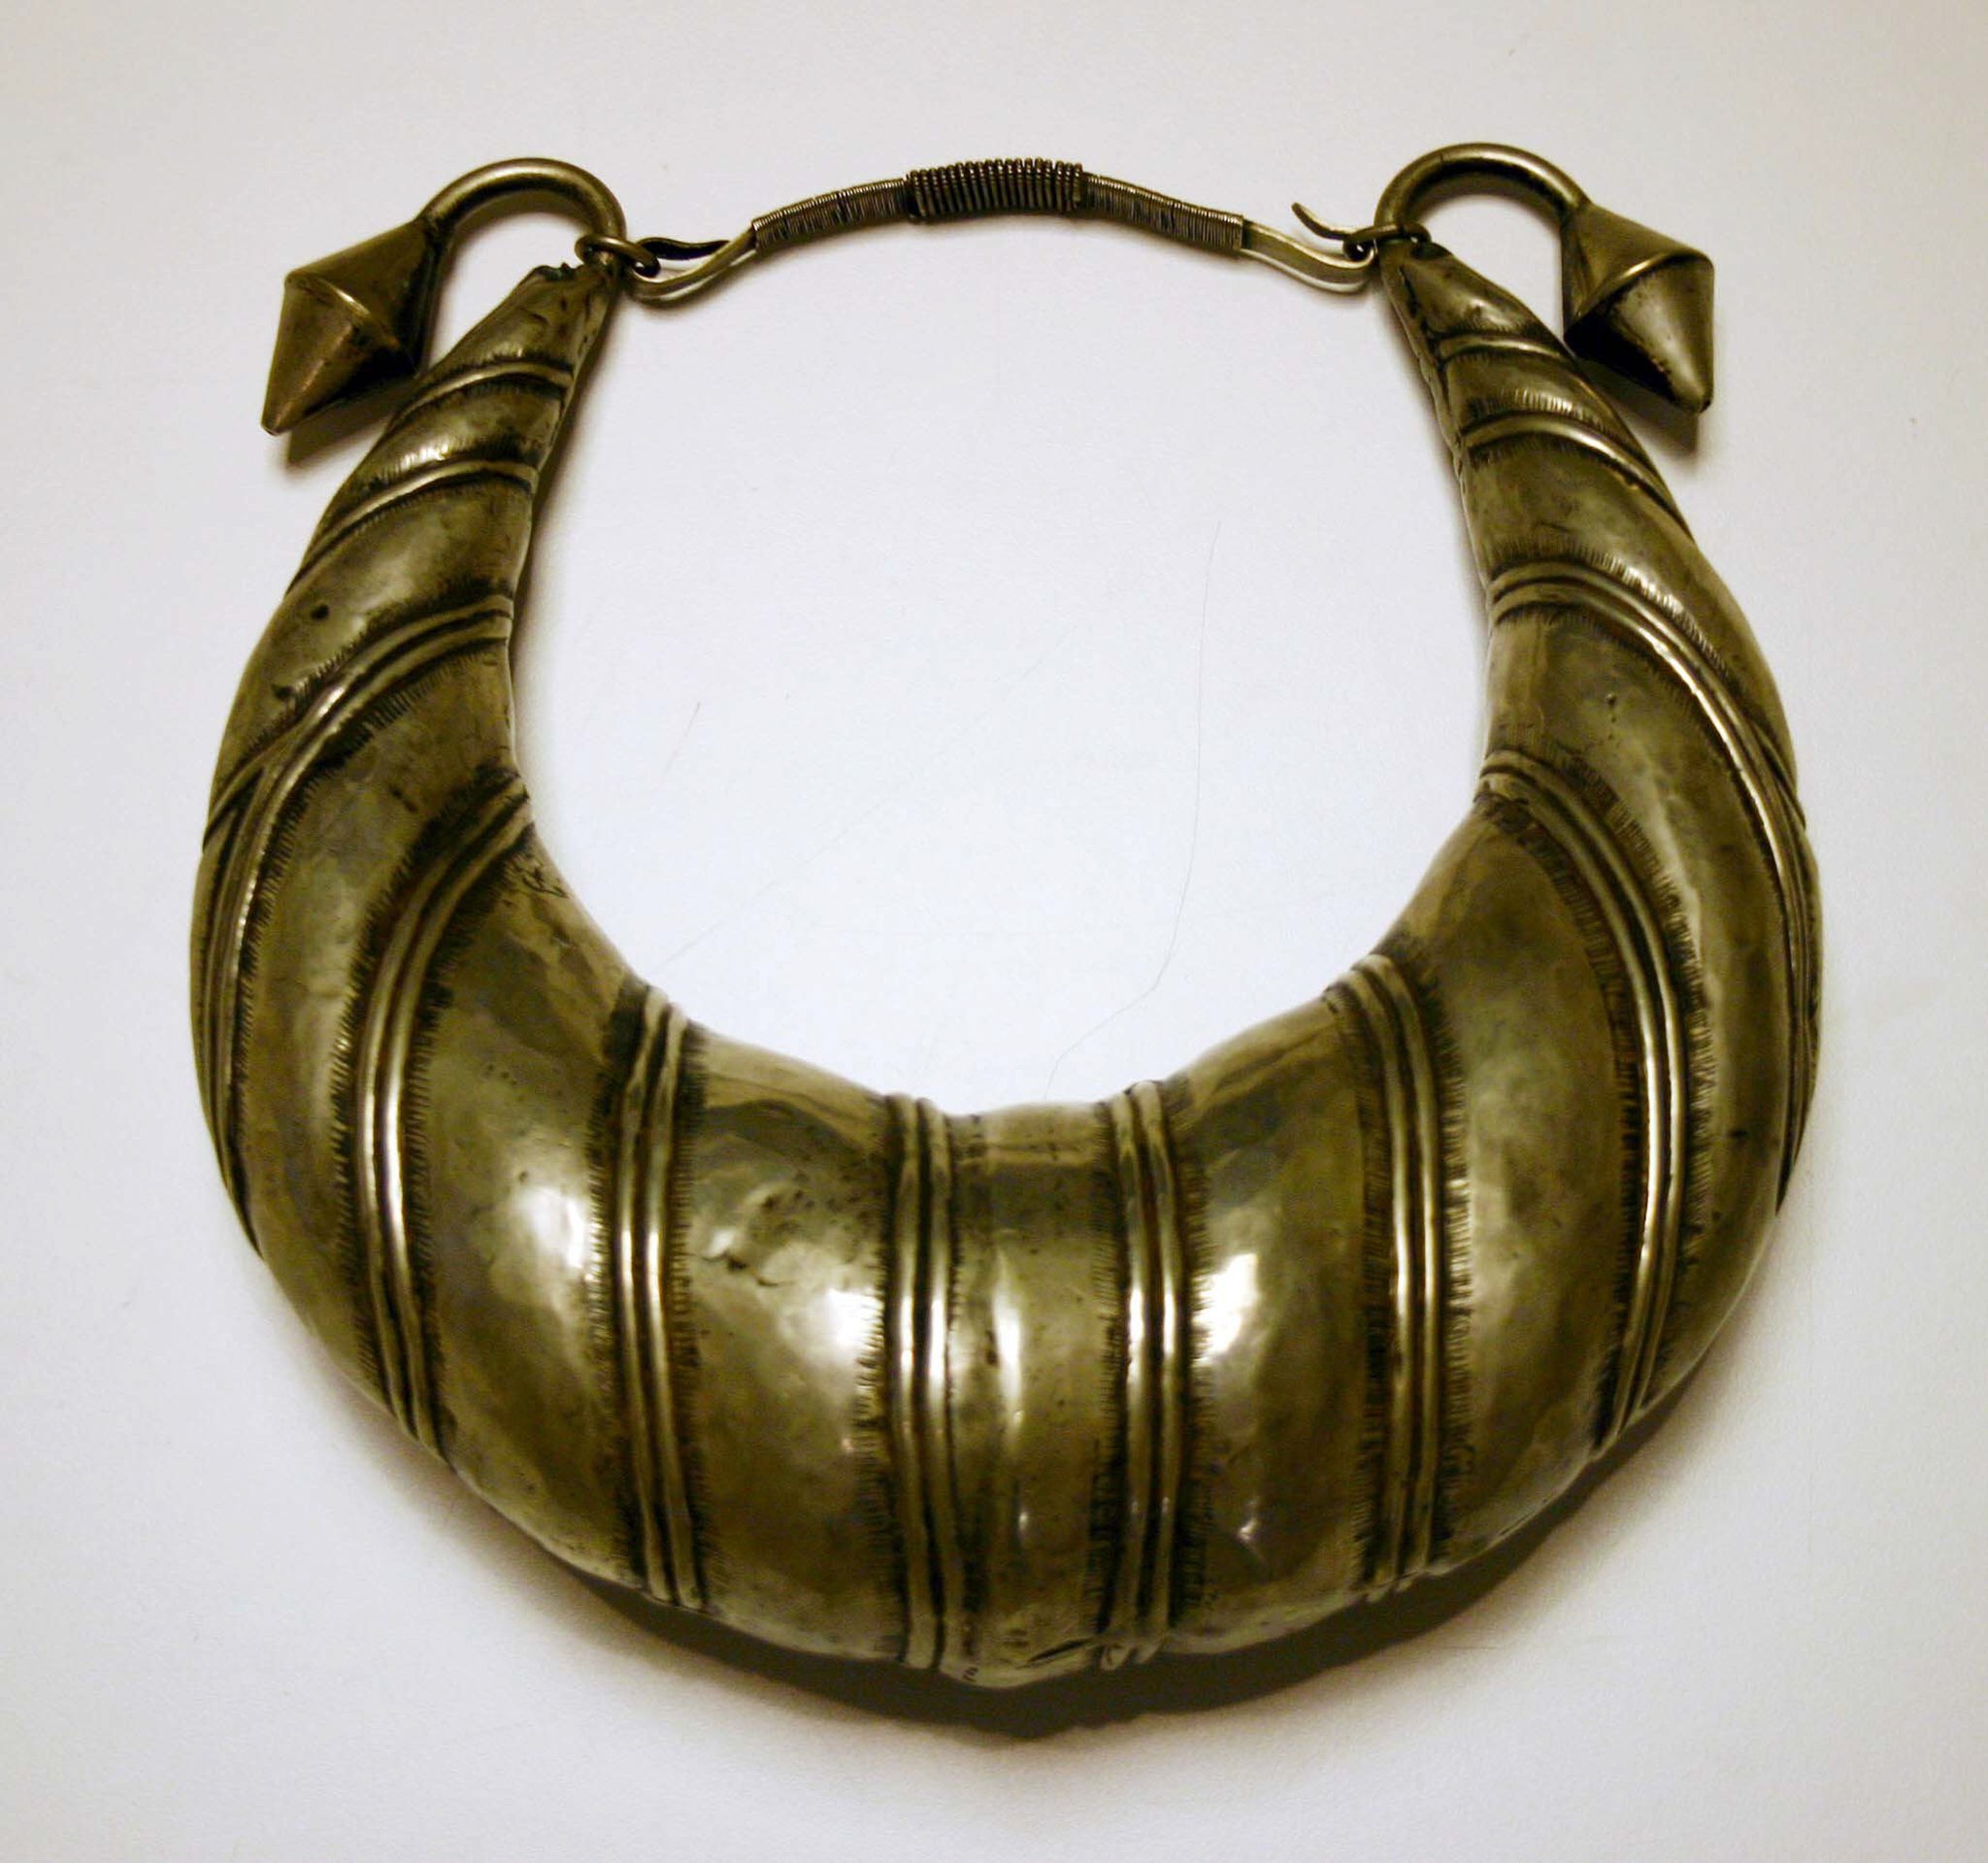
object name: necklace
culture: chinese, miao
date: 1920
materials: silver